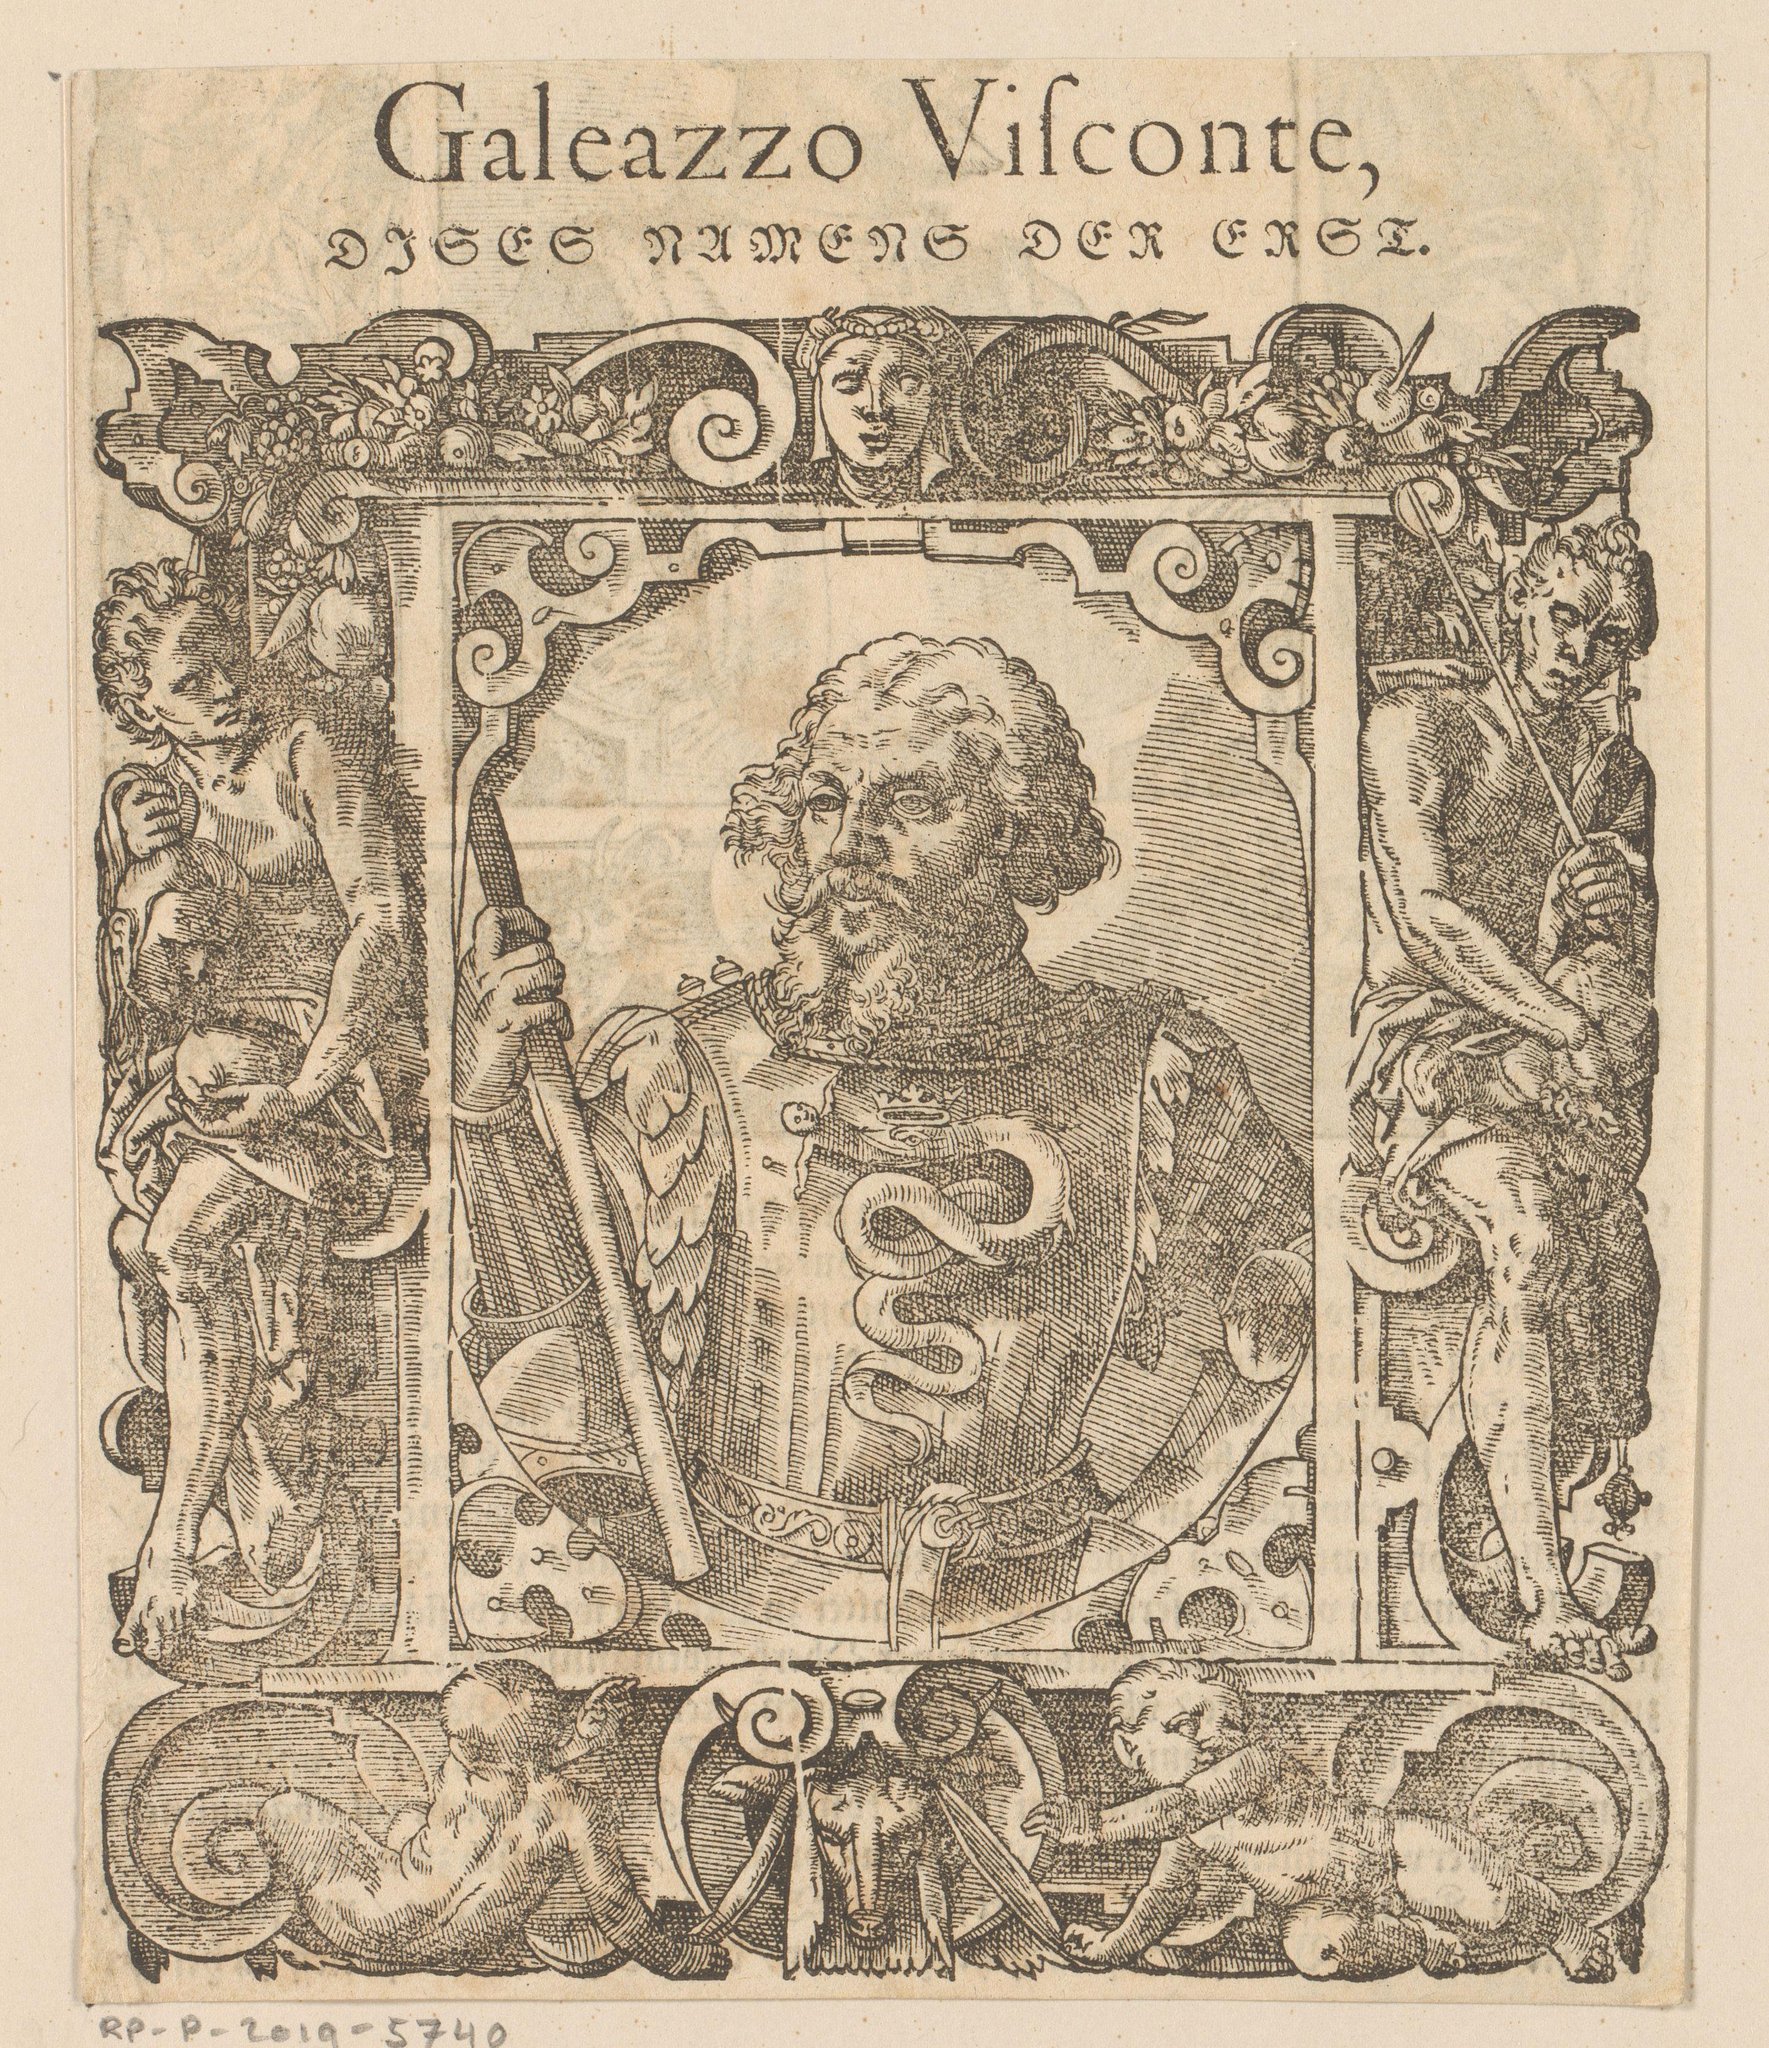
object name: print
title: Portret van Galeazzo I Visconti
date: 1587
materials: paper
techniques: letterpress printing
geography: basel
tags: historical persons, baton of general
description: Prent uit: Warhafftiger kurtzer Bericht von mannigerley Kriegs und anderen fürnemen (...). Bazel: Konrad Waldkirch, 1587, p. 58. Prent eerder verschenen in: Giovio, Paolo. Elogia virorum bellica virtute illustrium (...). Bazel: Peter Perna, 1575. Prent mogelijk ook gebruikt in latere publicaties.